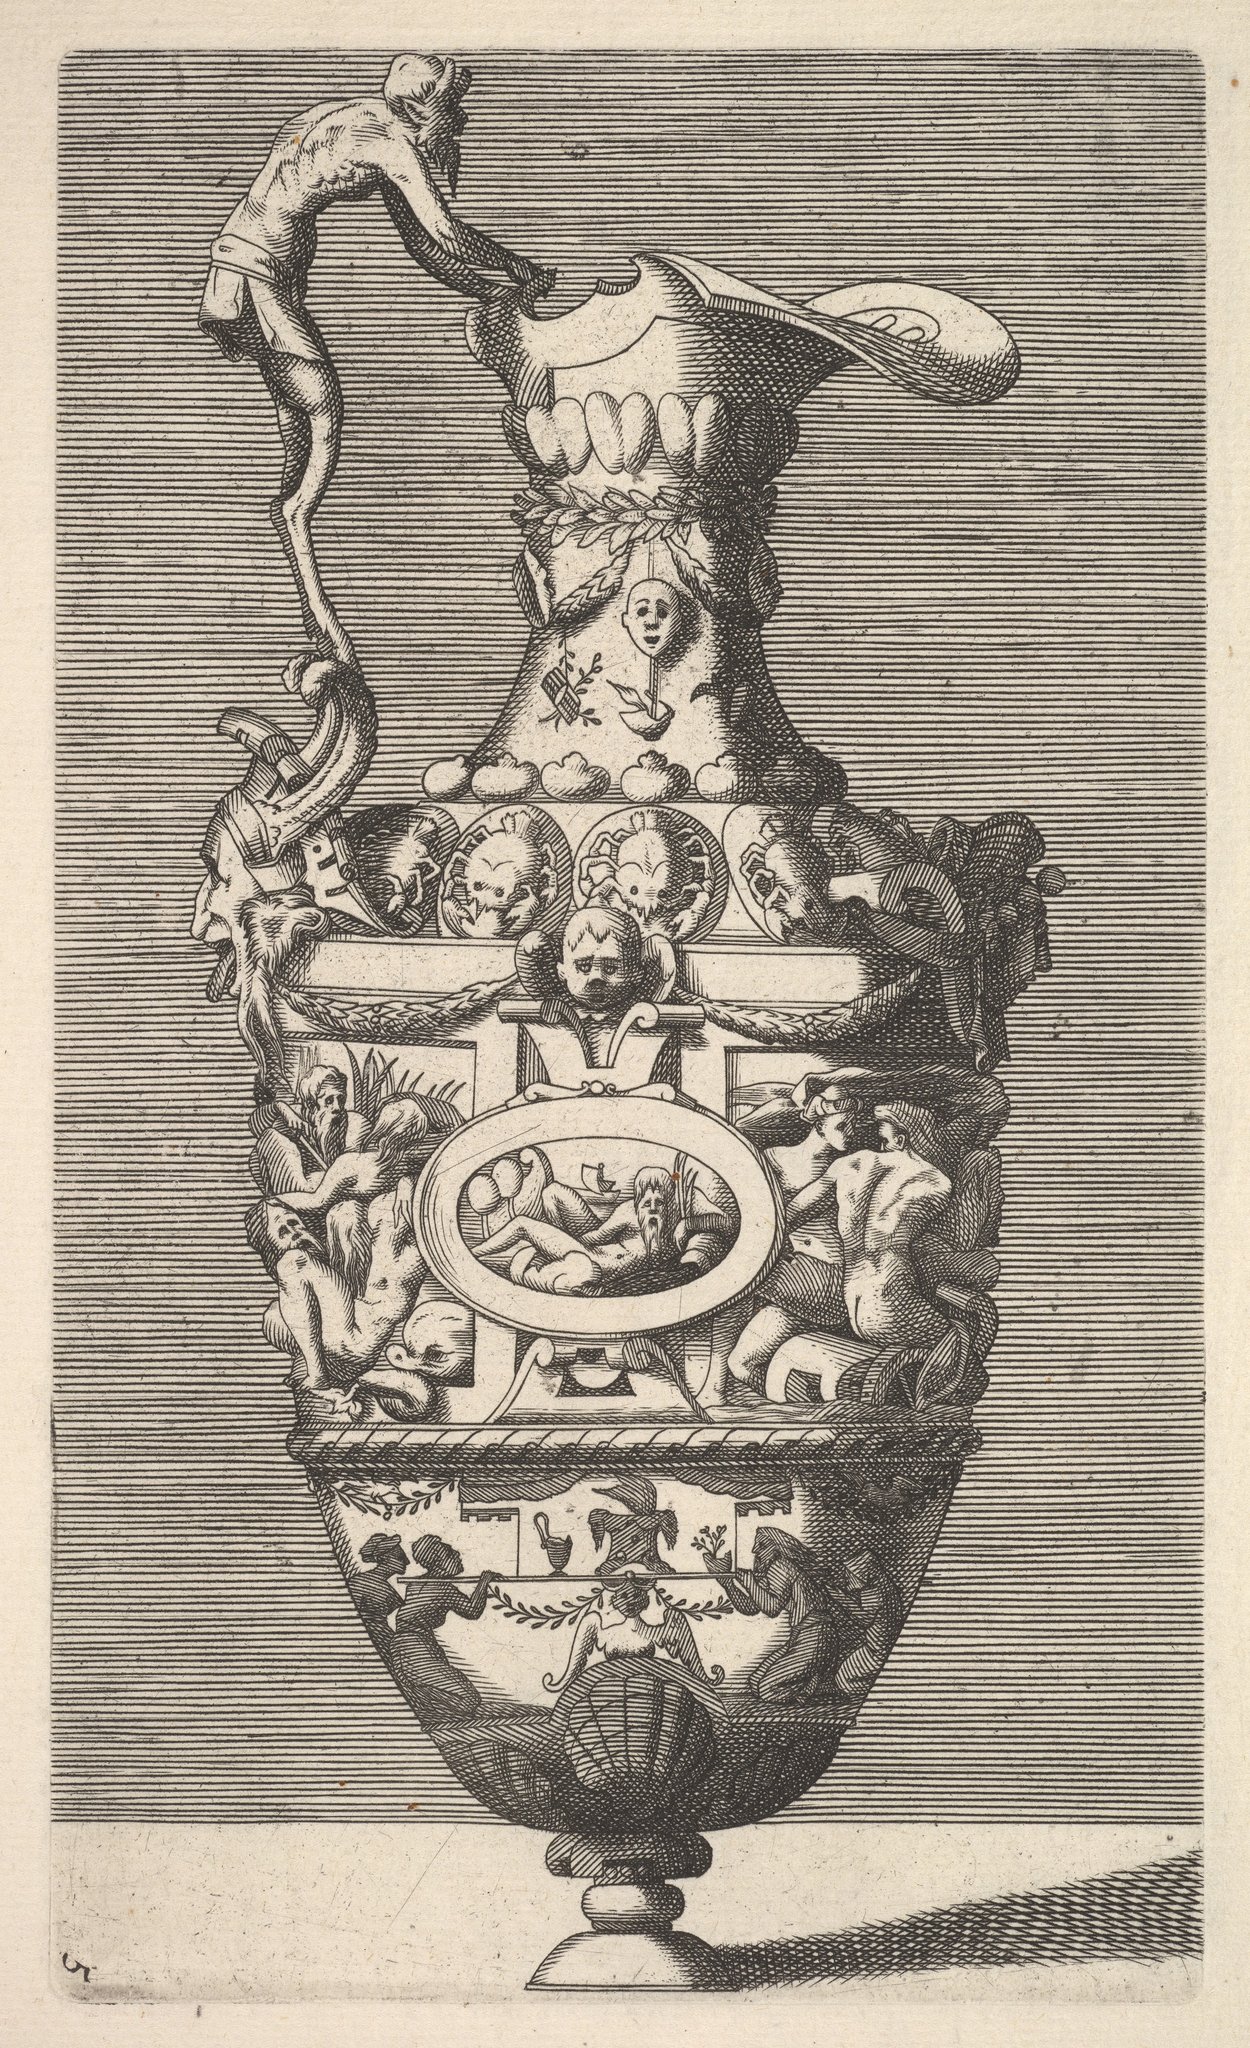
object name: print collection ornament architecture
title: Vase with a River God in an Oval Medallion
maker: rené boyvin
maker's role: artist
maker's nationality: french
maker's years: 1525-1598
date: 1601-1700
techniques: engraving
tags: vases